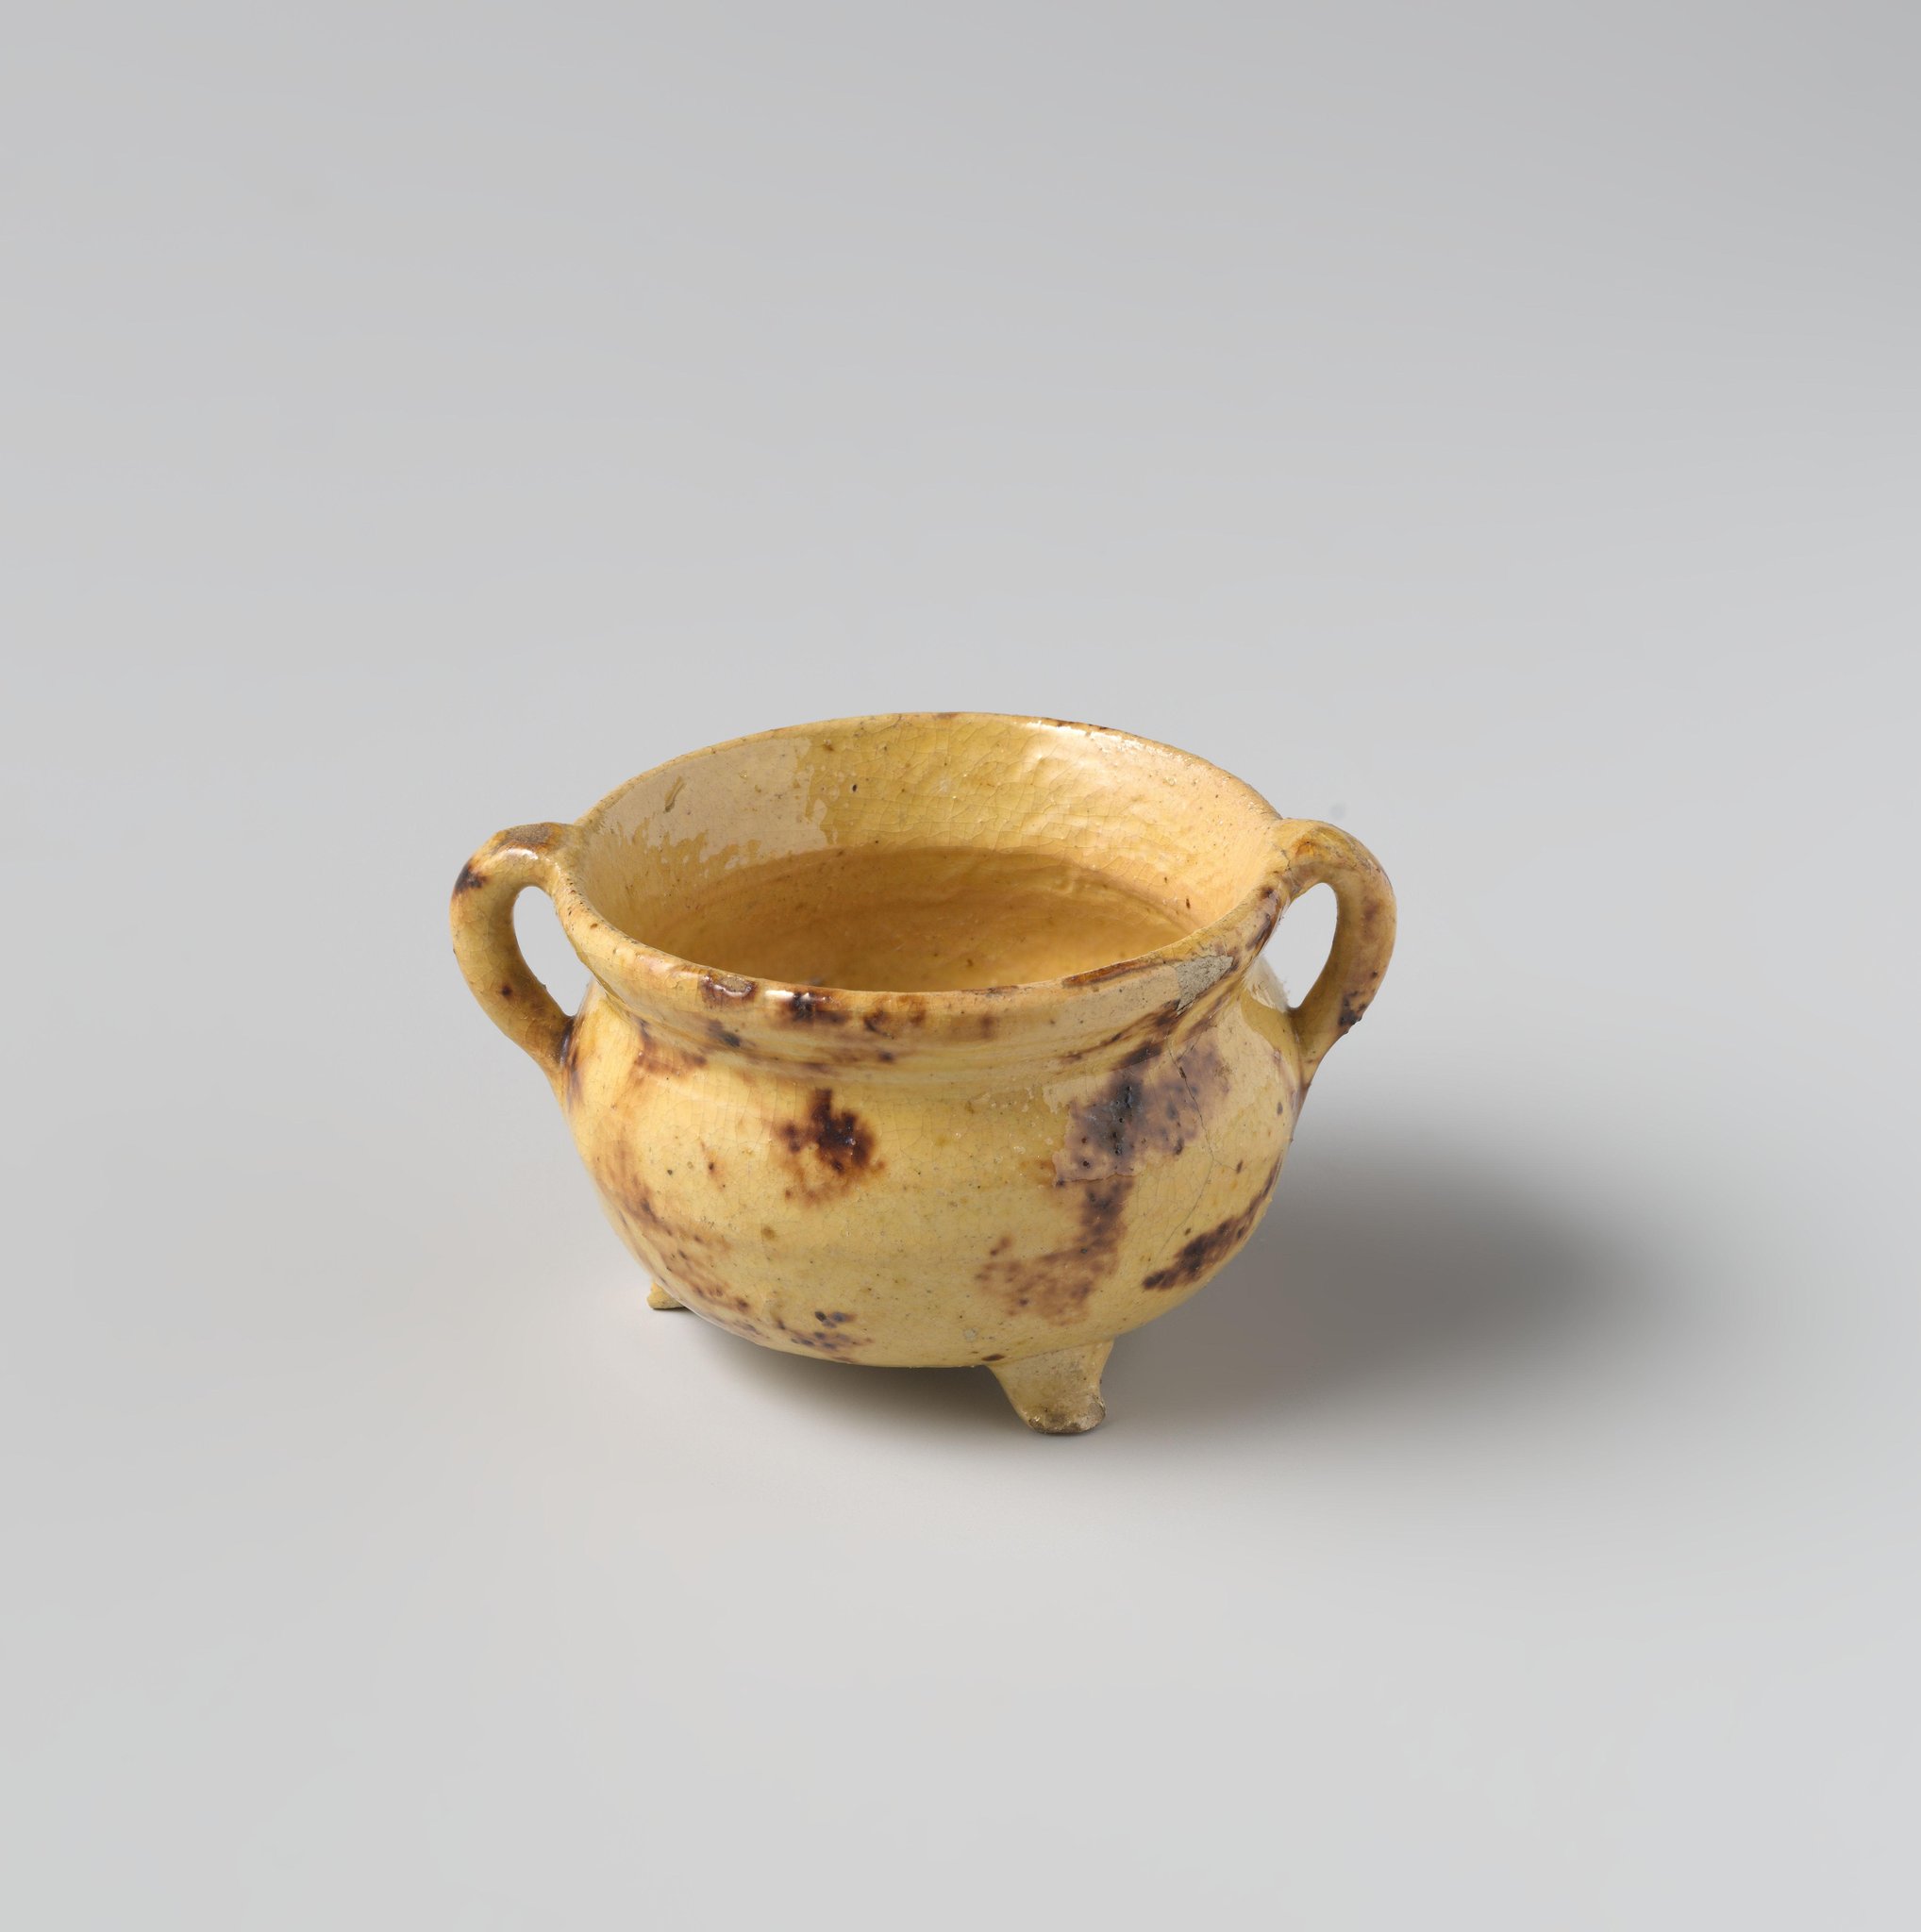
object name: miniature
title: Kookpot op drie poten, met uitstaande mondrand en twee oren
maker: Anonymous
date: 1675-1699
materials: earthenware, glaze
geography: netherlands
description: Kookpot van aardewerk met lichtgele scherf en een weinig bruingevlekte loodglazuur. De bolle pot op drie poten met uitstaande mondrand en twee oren